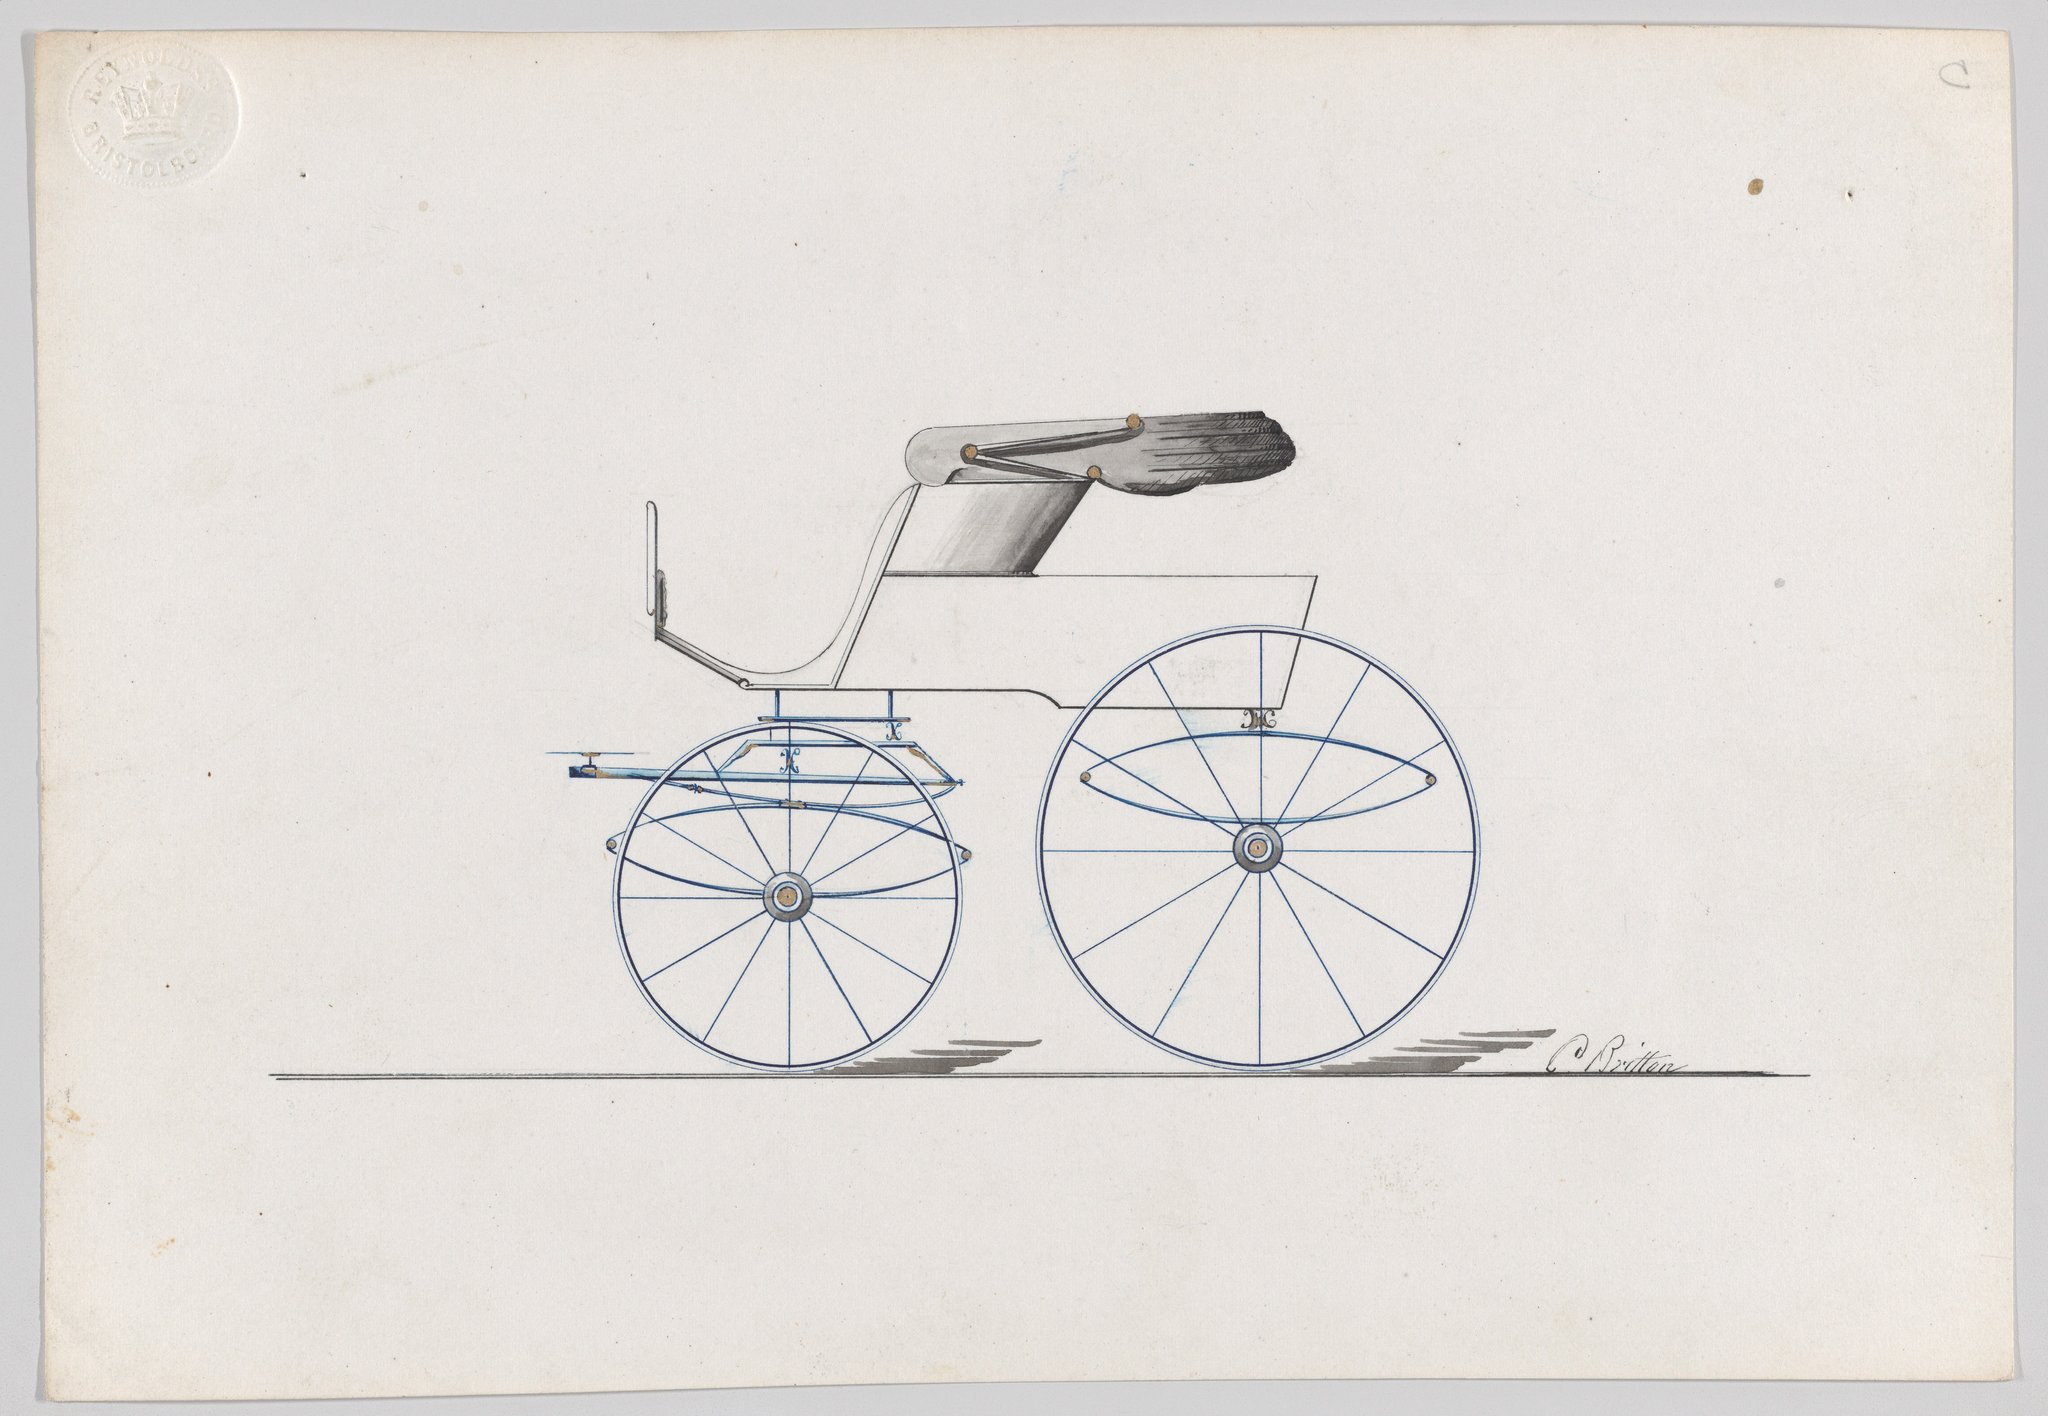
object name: drawing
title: Design for Stanhope Phaeton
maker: brewster & co.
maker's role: manufacturer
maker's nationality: american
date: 1850-1870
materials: gouache, ink, watercolor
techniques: pen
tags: carriages